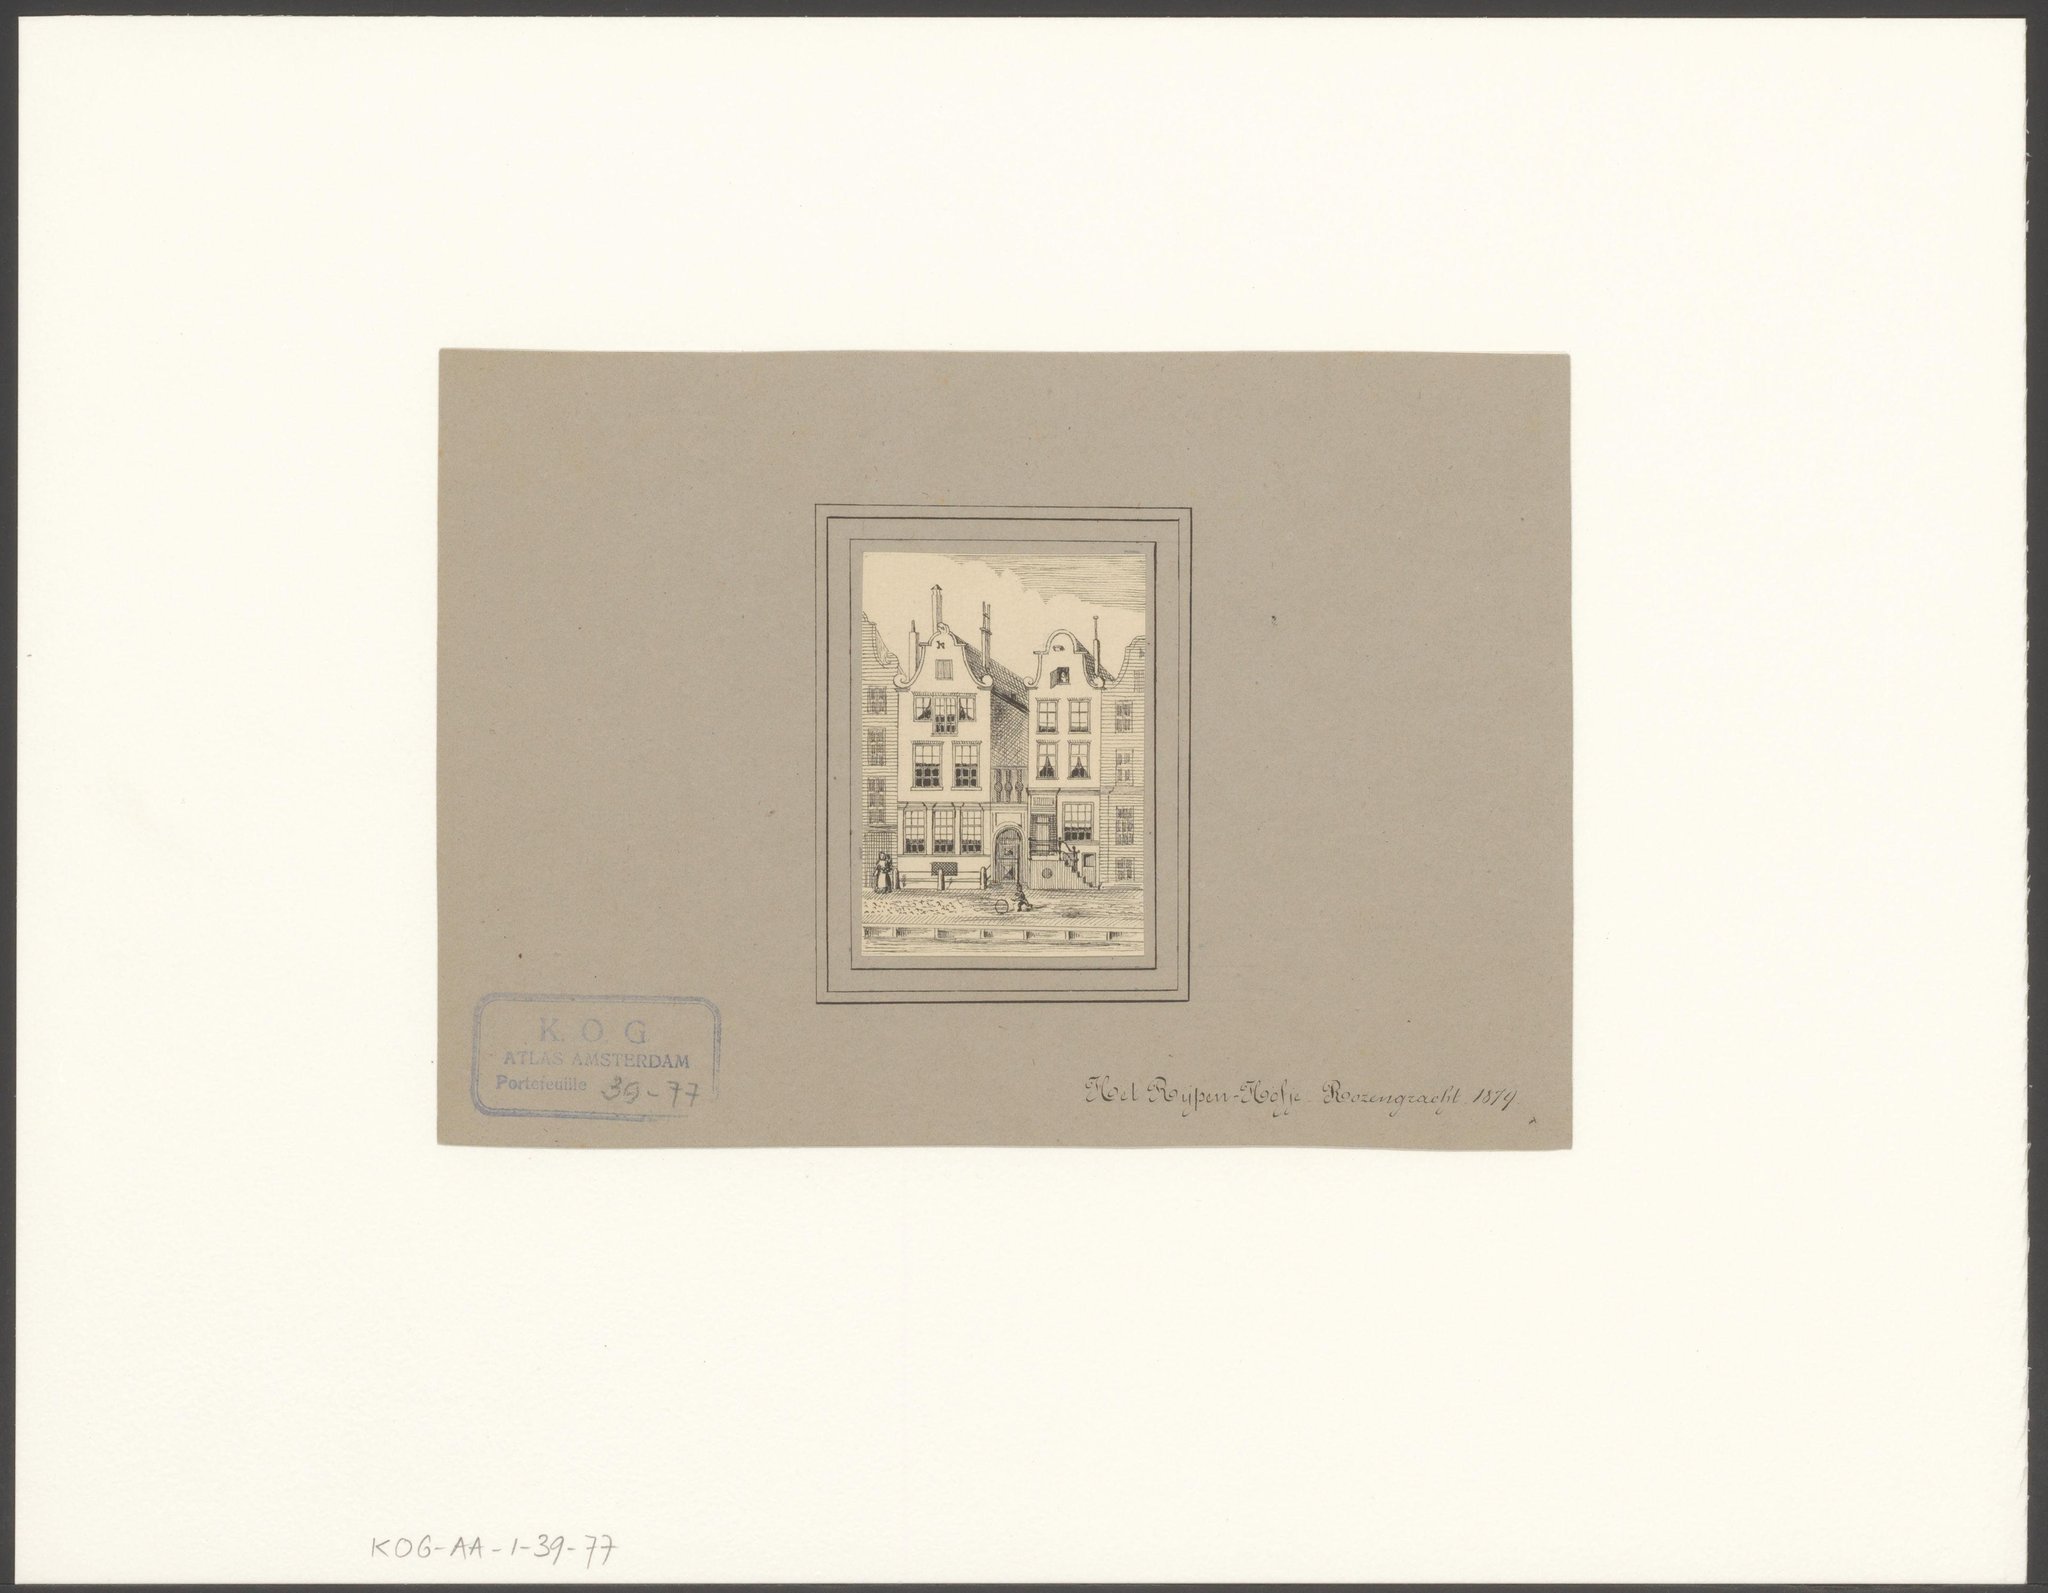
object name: drawing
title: Gezicht op het Rijpenhofje te Amsterdam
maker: Anonymous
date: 1879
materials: ink, paper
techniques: pen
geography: amsterdam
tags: alms-house (dutch: 'hofje'), street (+ city(-scape) with figures, staffage)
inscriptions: collector's mark: Lugt 1641b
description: Onderwerpsrubriek binnen de Atlas Amsterdam: Armwezen en liefdadige instellingen: III. Verschillende gestichten en instellingen / Hofjes: Rapen- en Bosscherhofje - Regenboog's liefde Hofje - Rijper-Hofje.